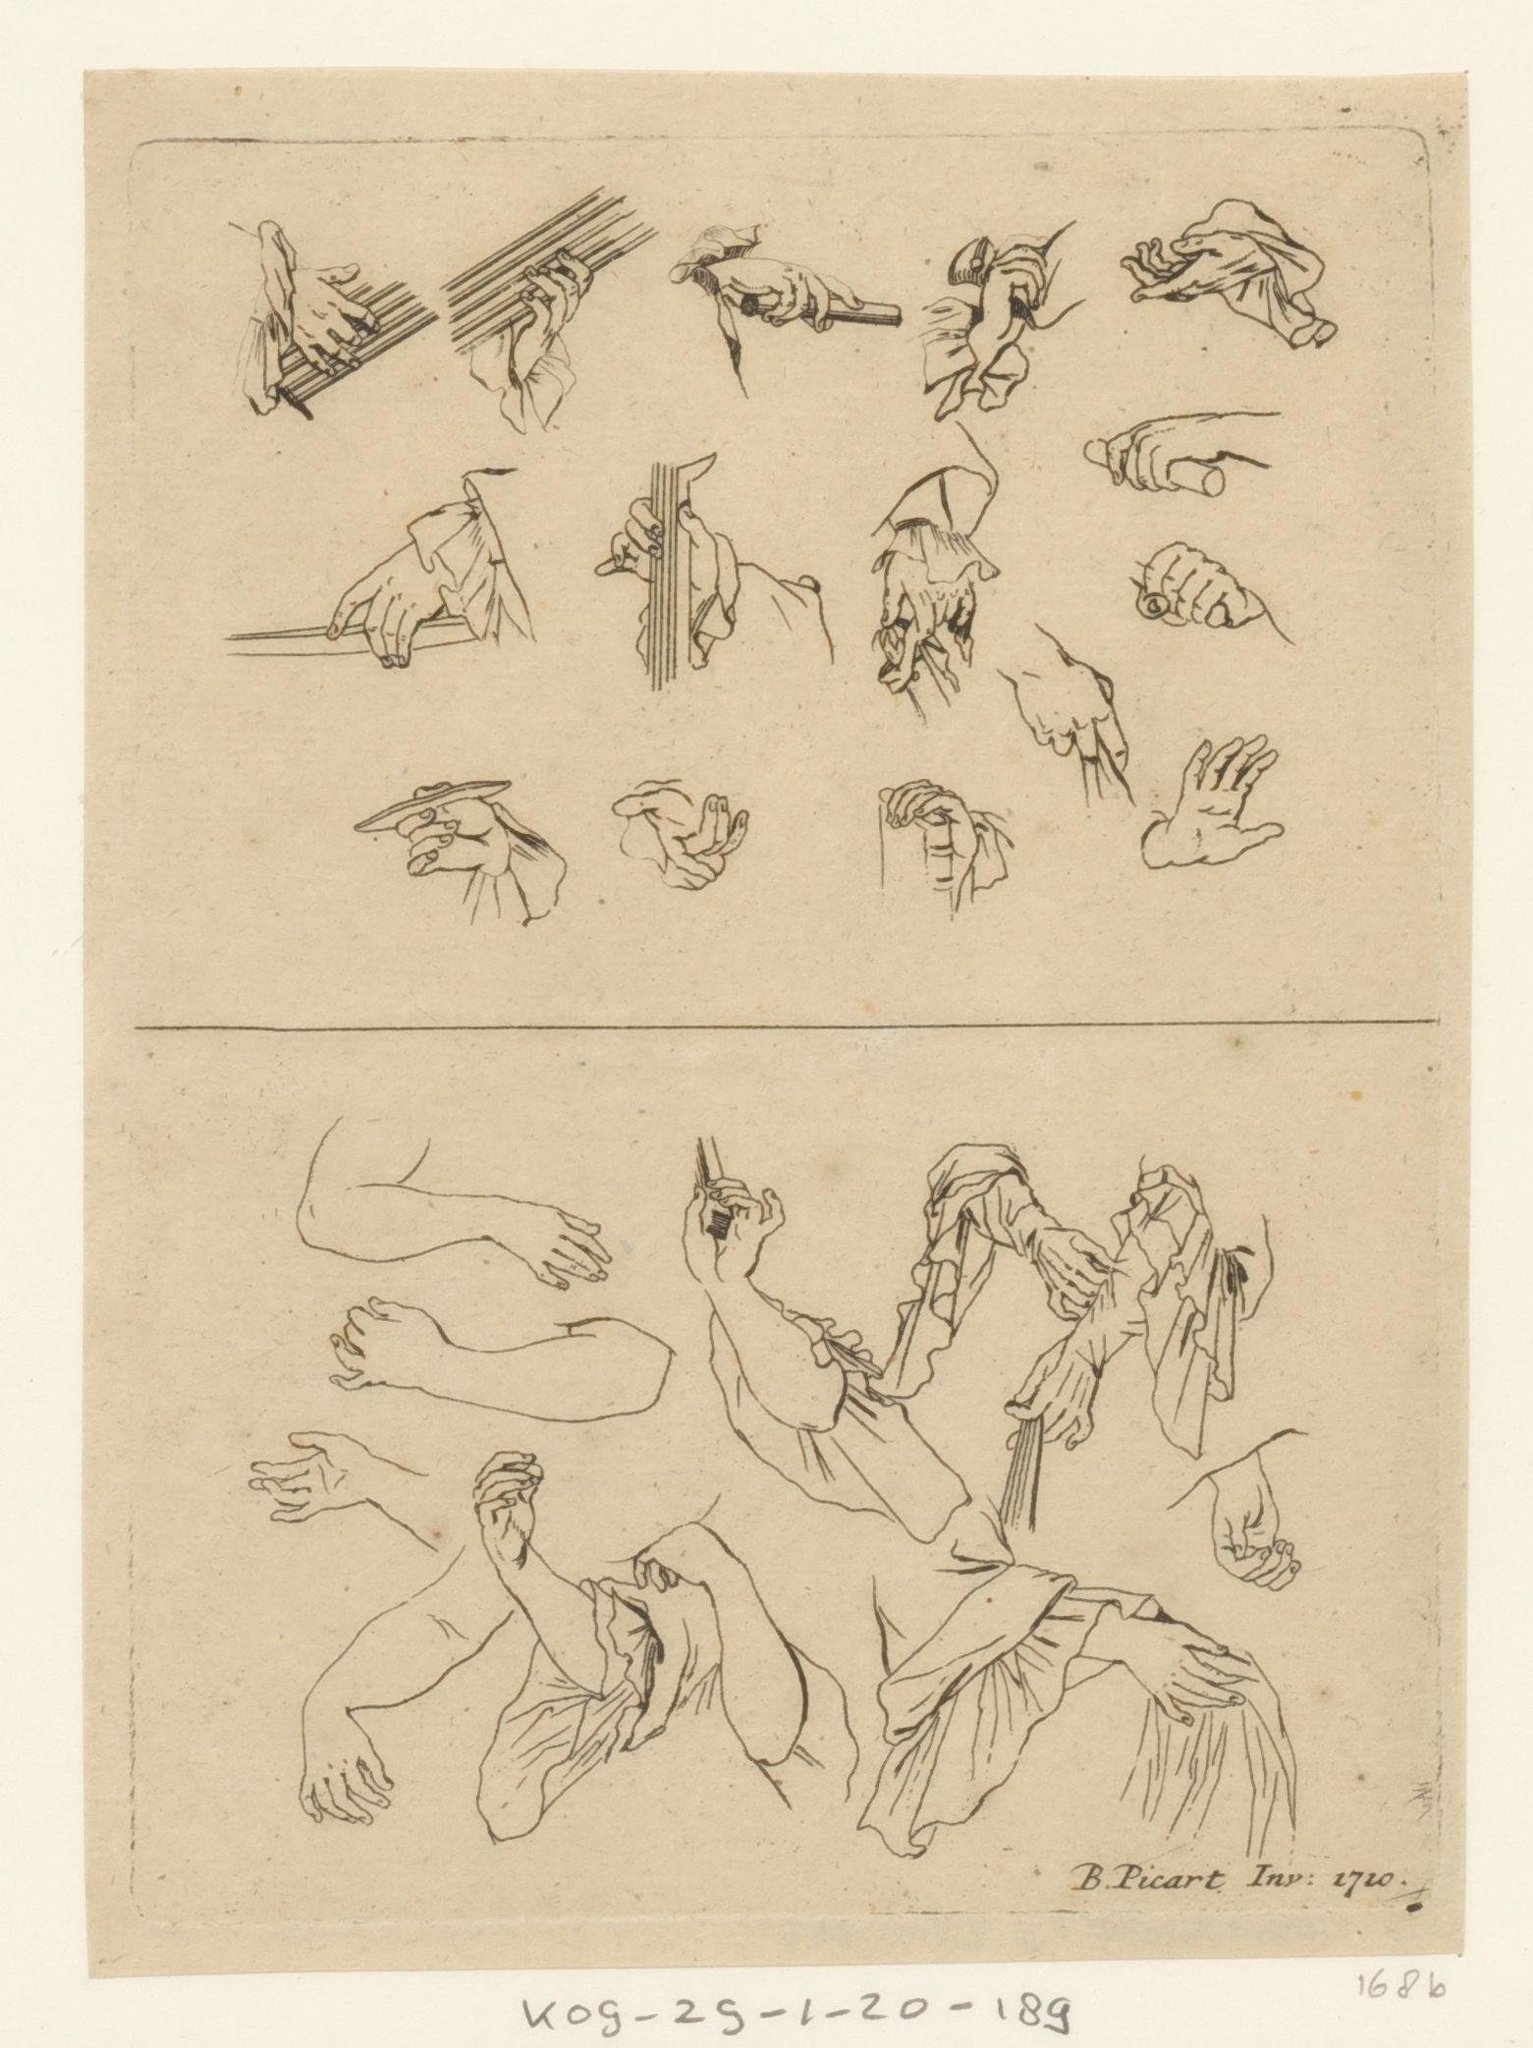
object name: print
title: Studie met allerlei posities van handen en modestudie over het draperen van een mouw rond een arm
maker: bernard picart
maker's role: draughtsman, print maker, publisher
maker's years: 1673-1733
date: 1710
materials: paper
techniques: etching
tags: courtesy, manners; etiquette, postures and gestures of arms and hands, fashion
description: Studieblad met handen in verschillende houdingen. Onderwerpsrubrieken binnen de Atlas Zeden en Gewoonten: Zeden en Gewoonten in Engeren Zin, De Kleeding, Kleederdrachten (tijdvakken), Lodewijk XIV (1650 – 1720). Het allonge tijdvak).